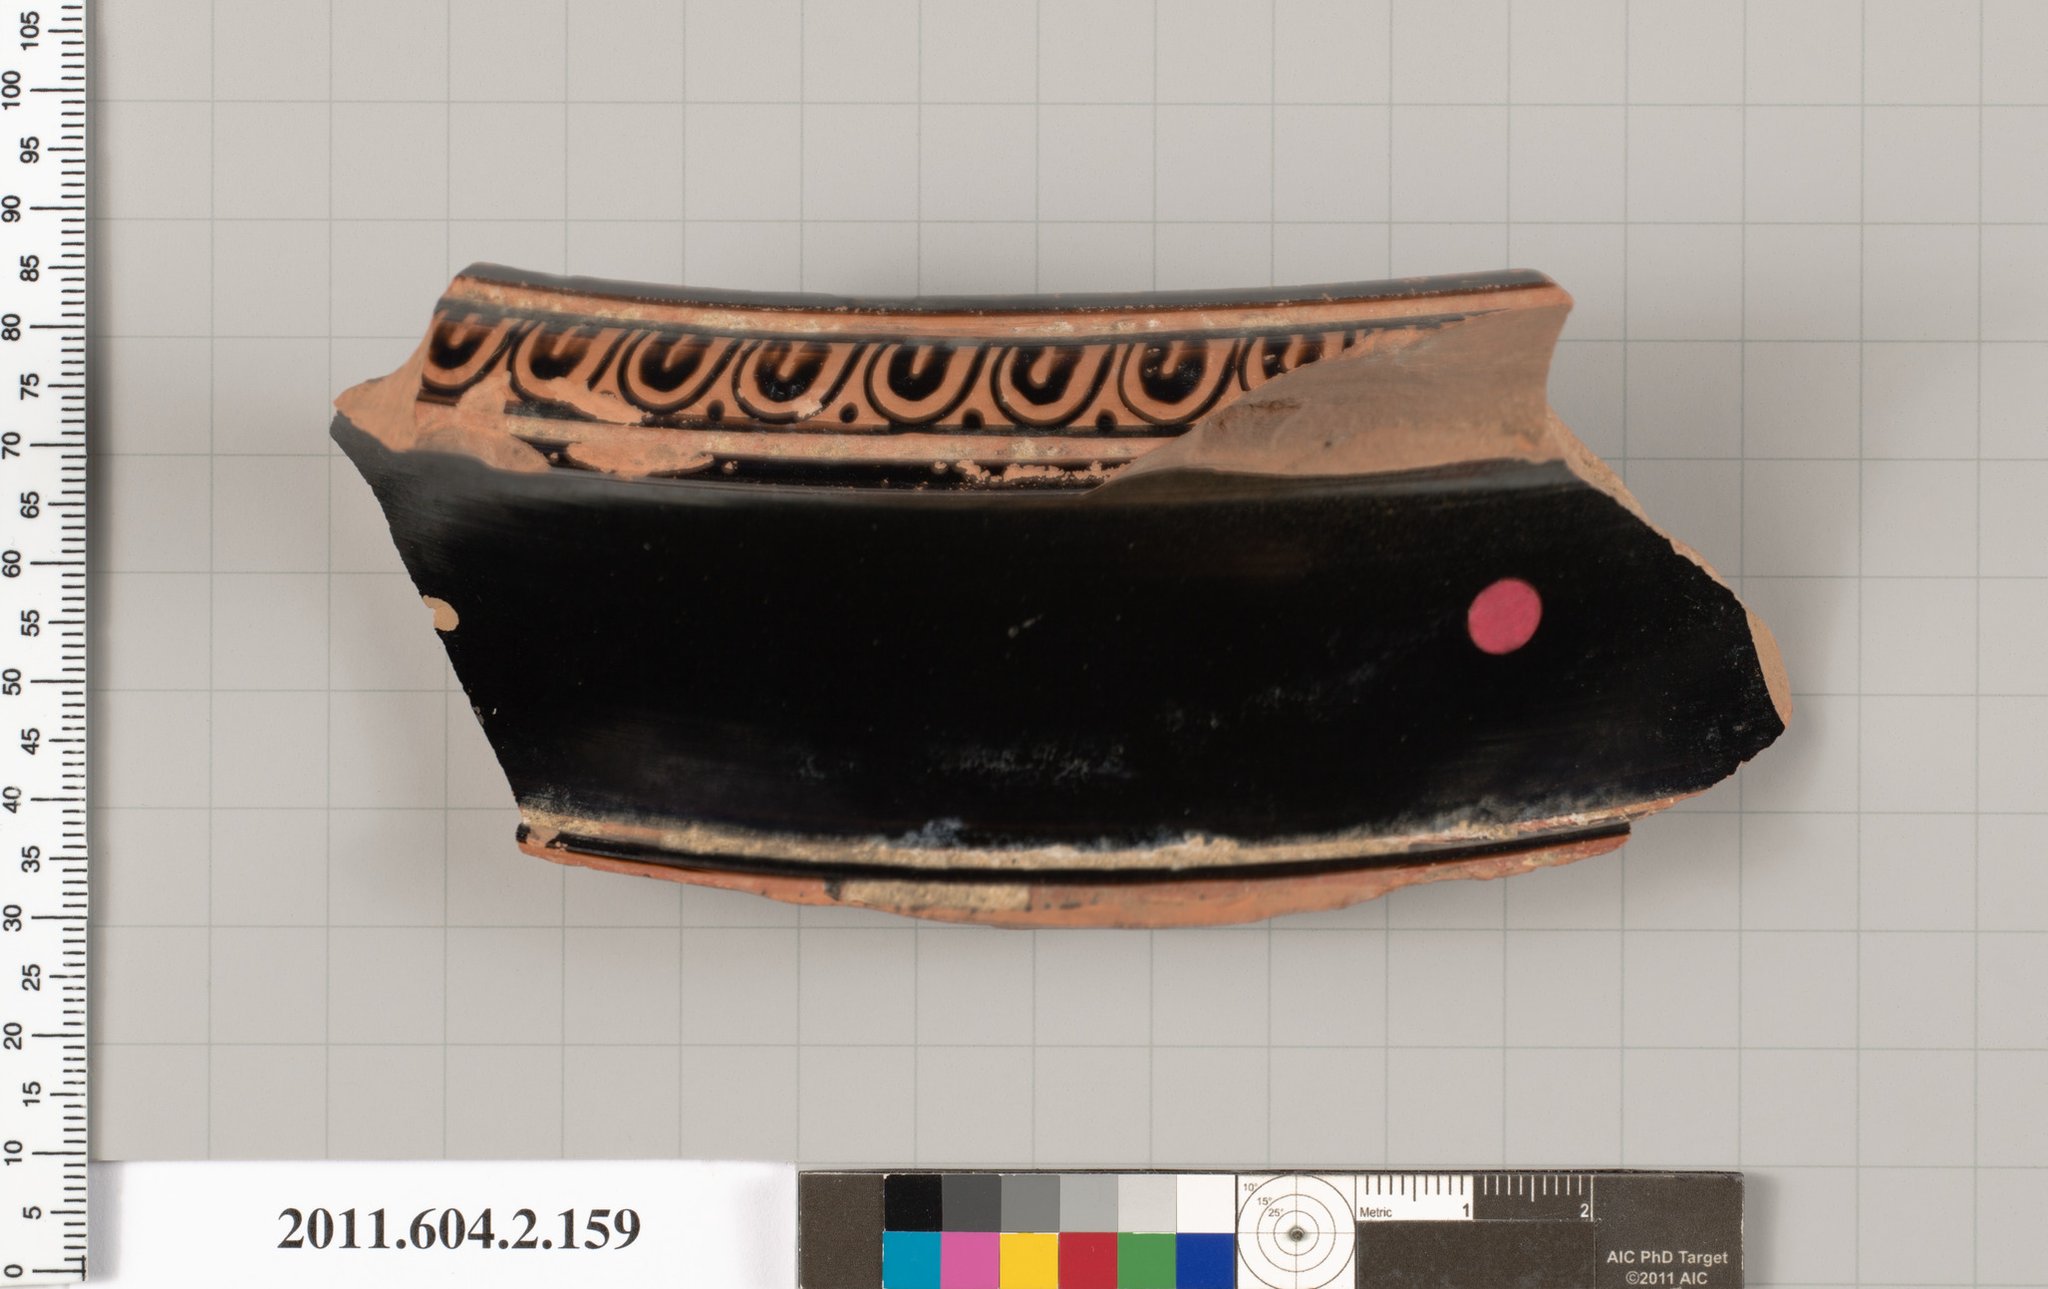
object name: stamnos fragment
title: Terracotta fragment of a stamnos (jar)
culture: greek, attic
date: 450-430 BCE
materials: terracotta